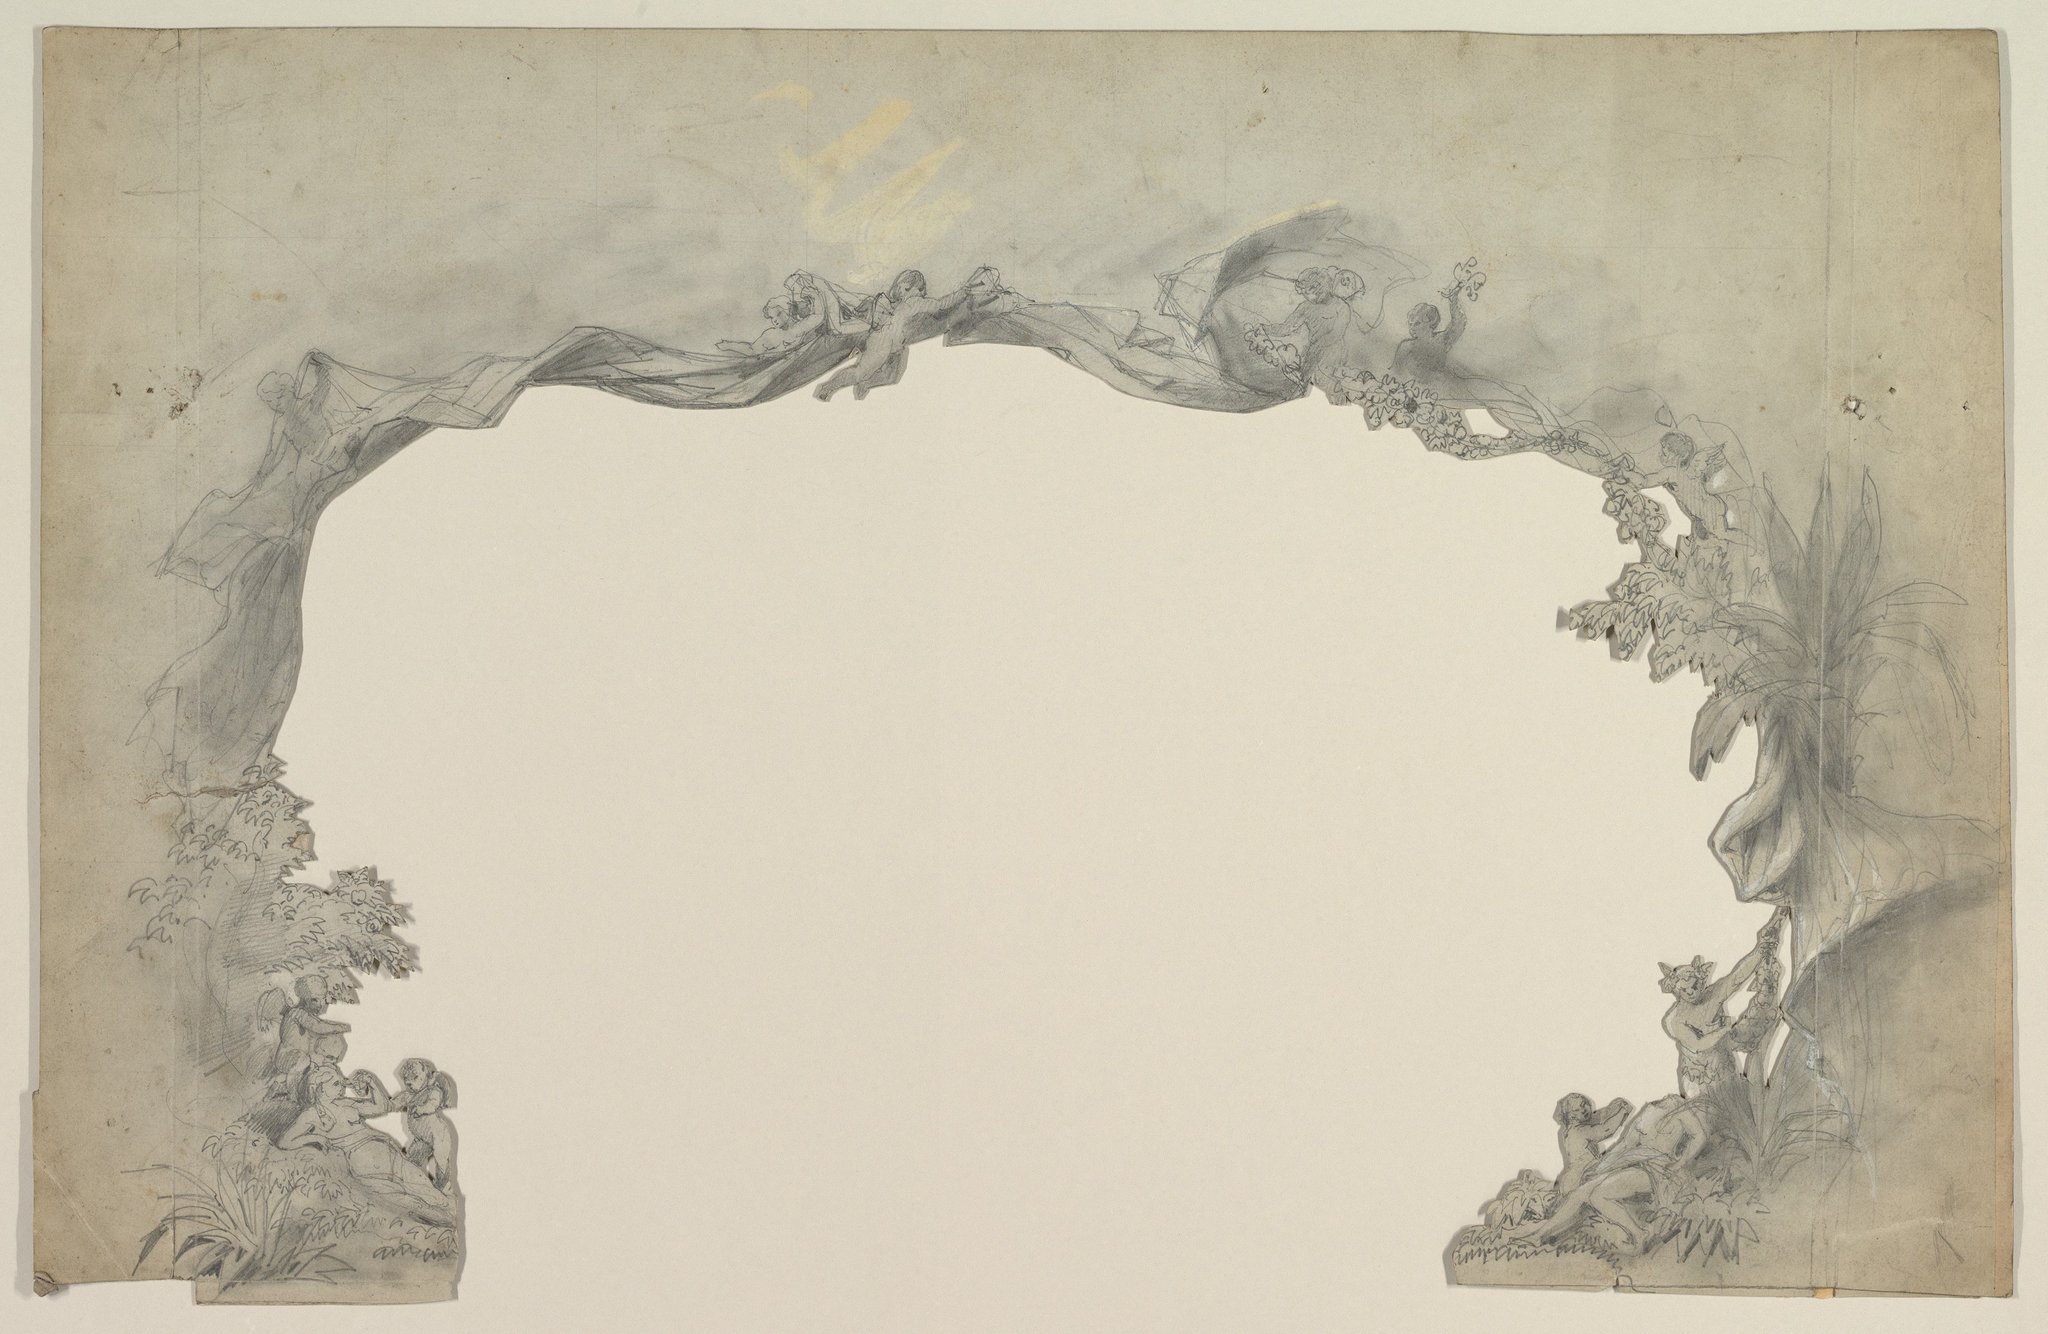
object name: drawing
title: Design for a Stage Set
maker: eugène cicéri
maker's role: artist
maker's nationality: french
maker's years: 1813-1890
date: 1830-1890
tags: stage design